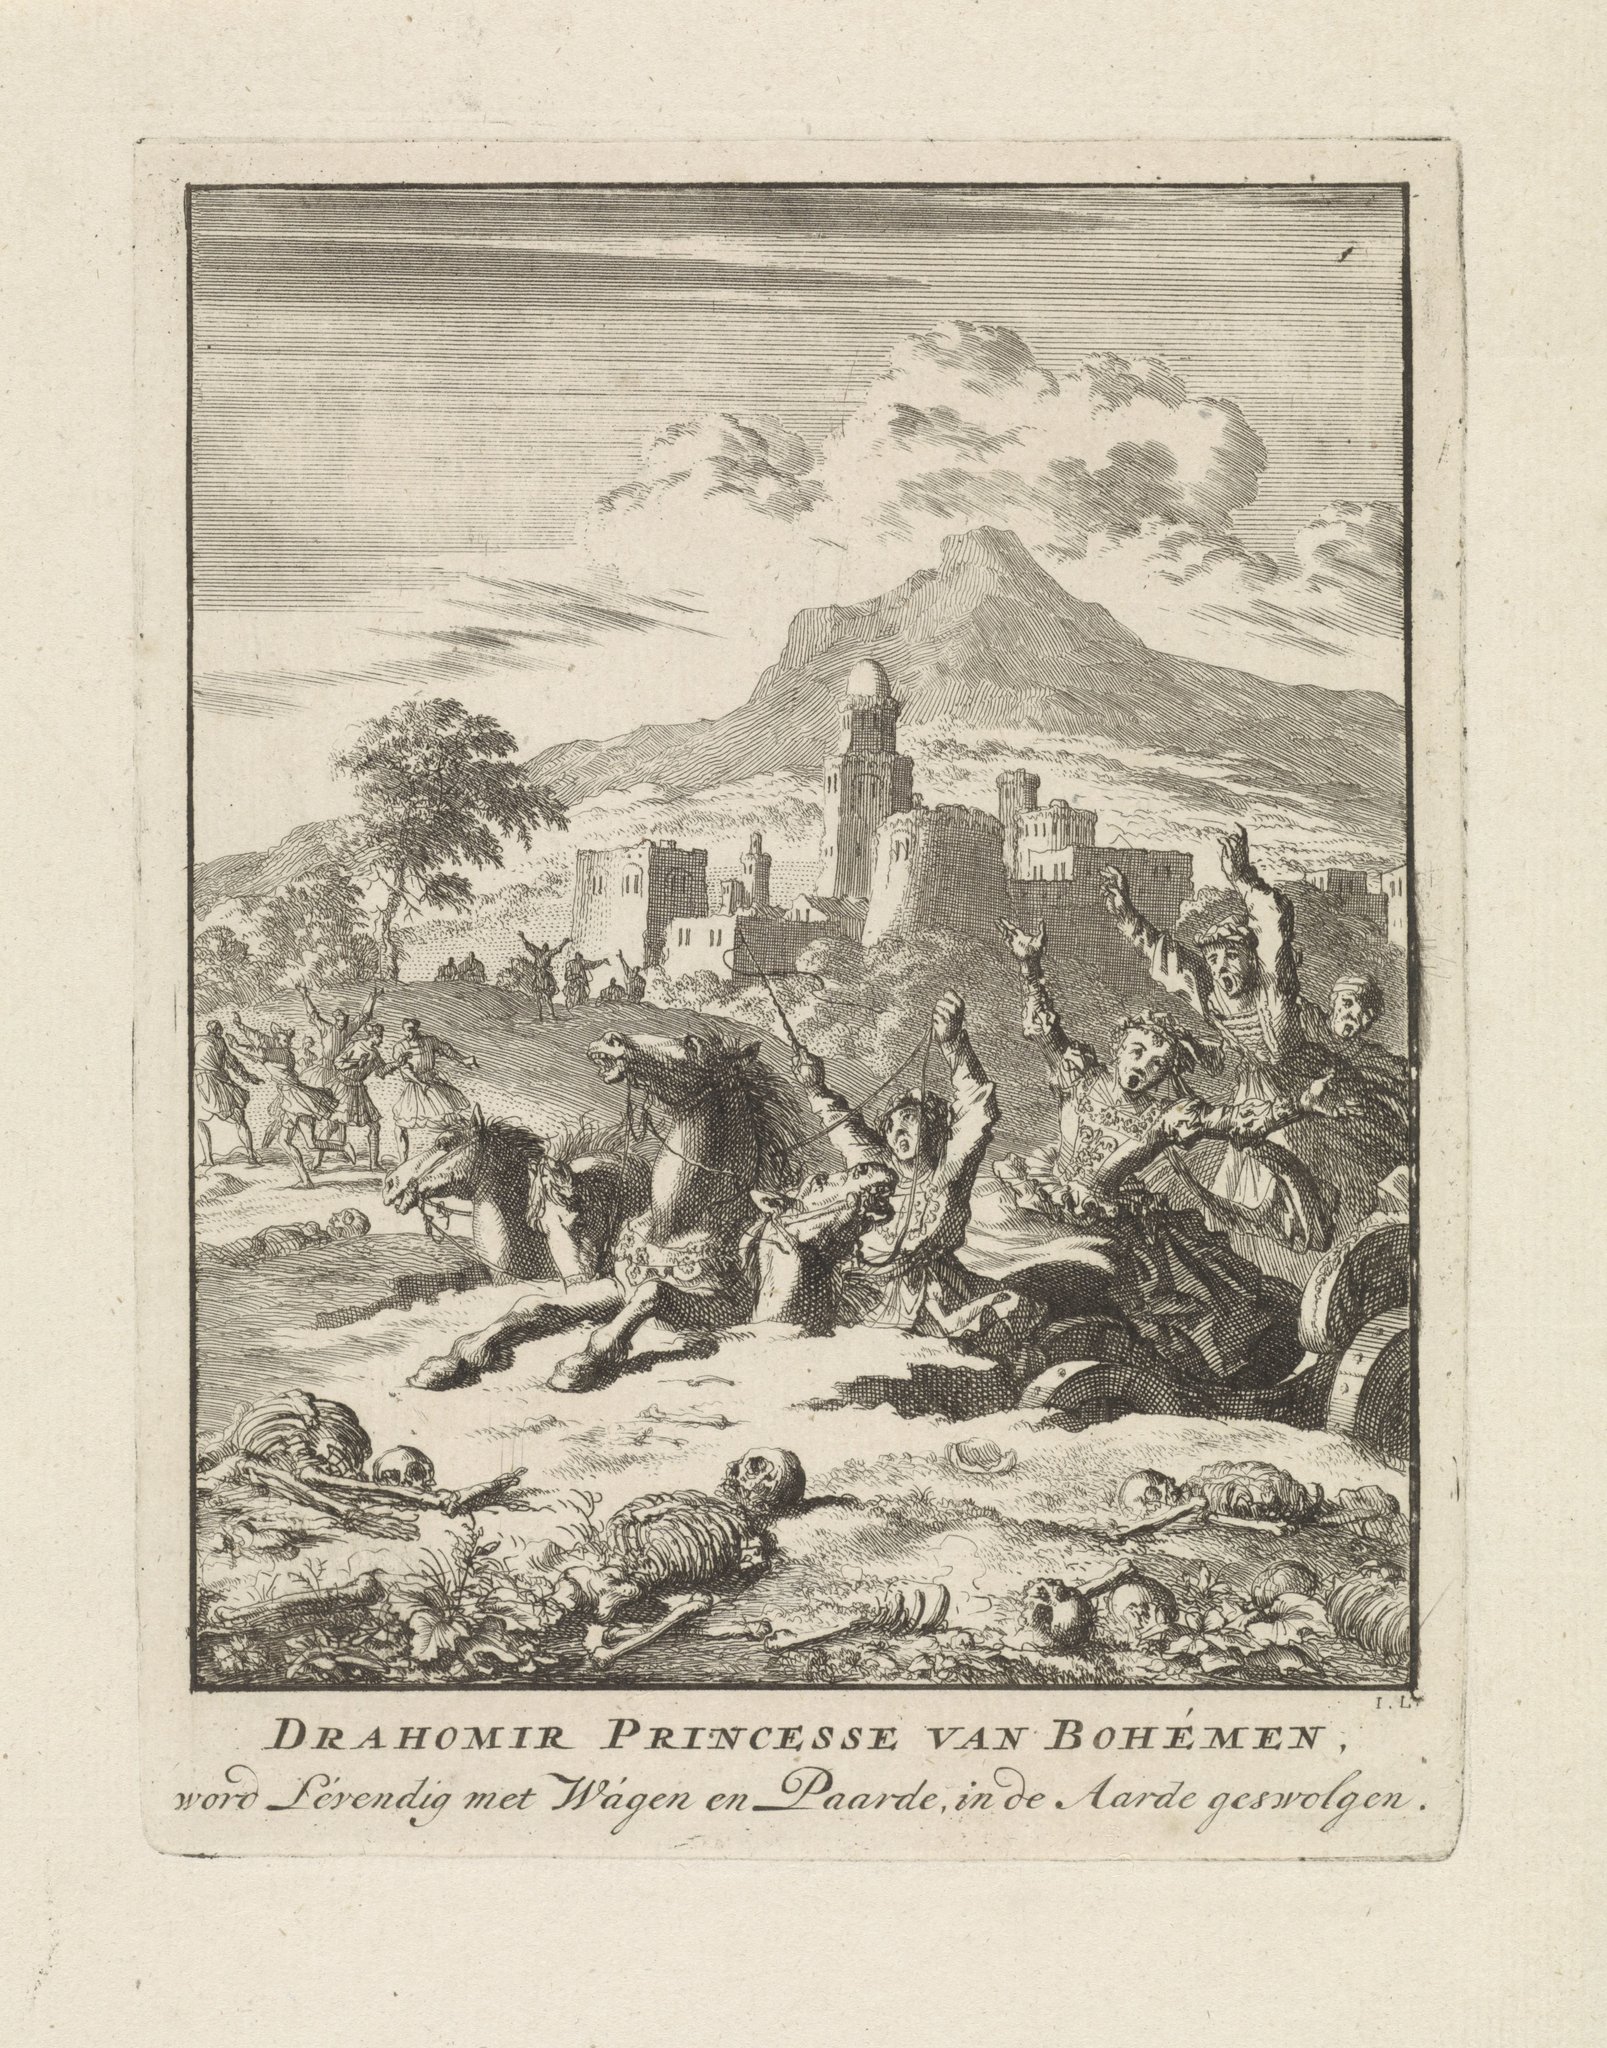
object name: print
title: Drahomir Princesse van Bohemen, word Levendig met Wagen en Paarde, in de Aarde geswolgen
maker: jan luyken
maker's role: draughtsman, print maker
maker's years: 1649-1712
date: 1699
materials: paper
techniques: etching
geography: amsterdam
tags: prague, buried alive (violent death), four-wheeled vehicle drawn by three animals, earthquake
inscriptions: collector's mark: Lugt 2228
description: Een aardbeving verzwelgt het rijtuig van koningin Drahomira van Bohemen. De koningin en haar gevolg verdwijnen in de aardbodem. Op de achtergrond de stad Praag.